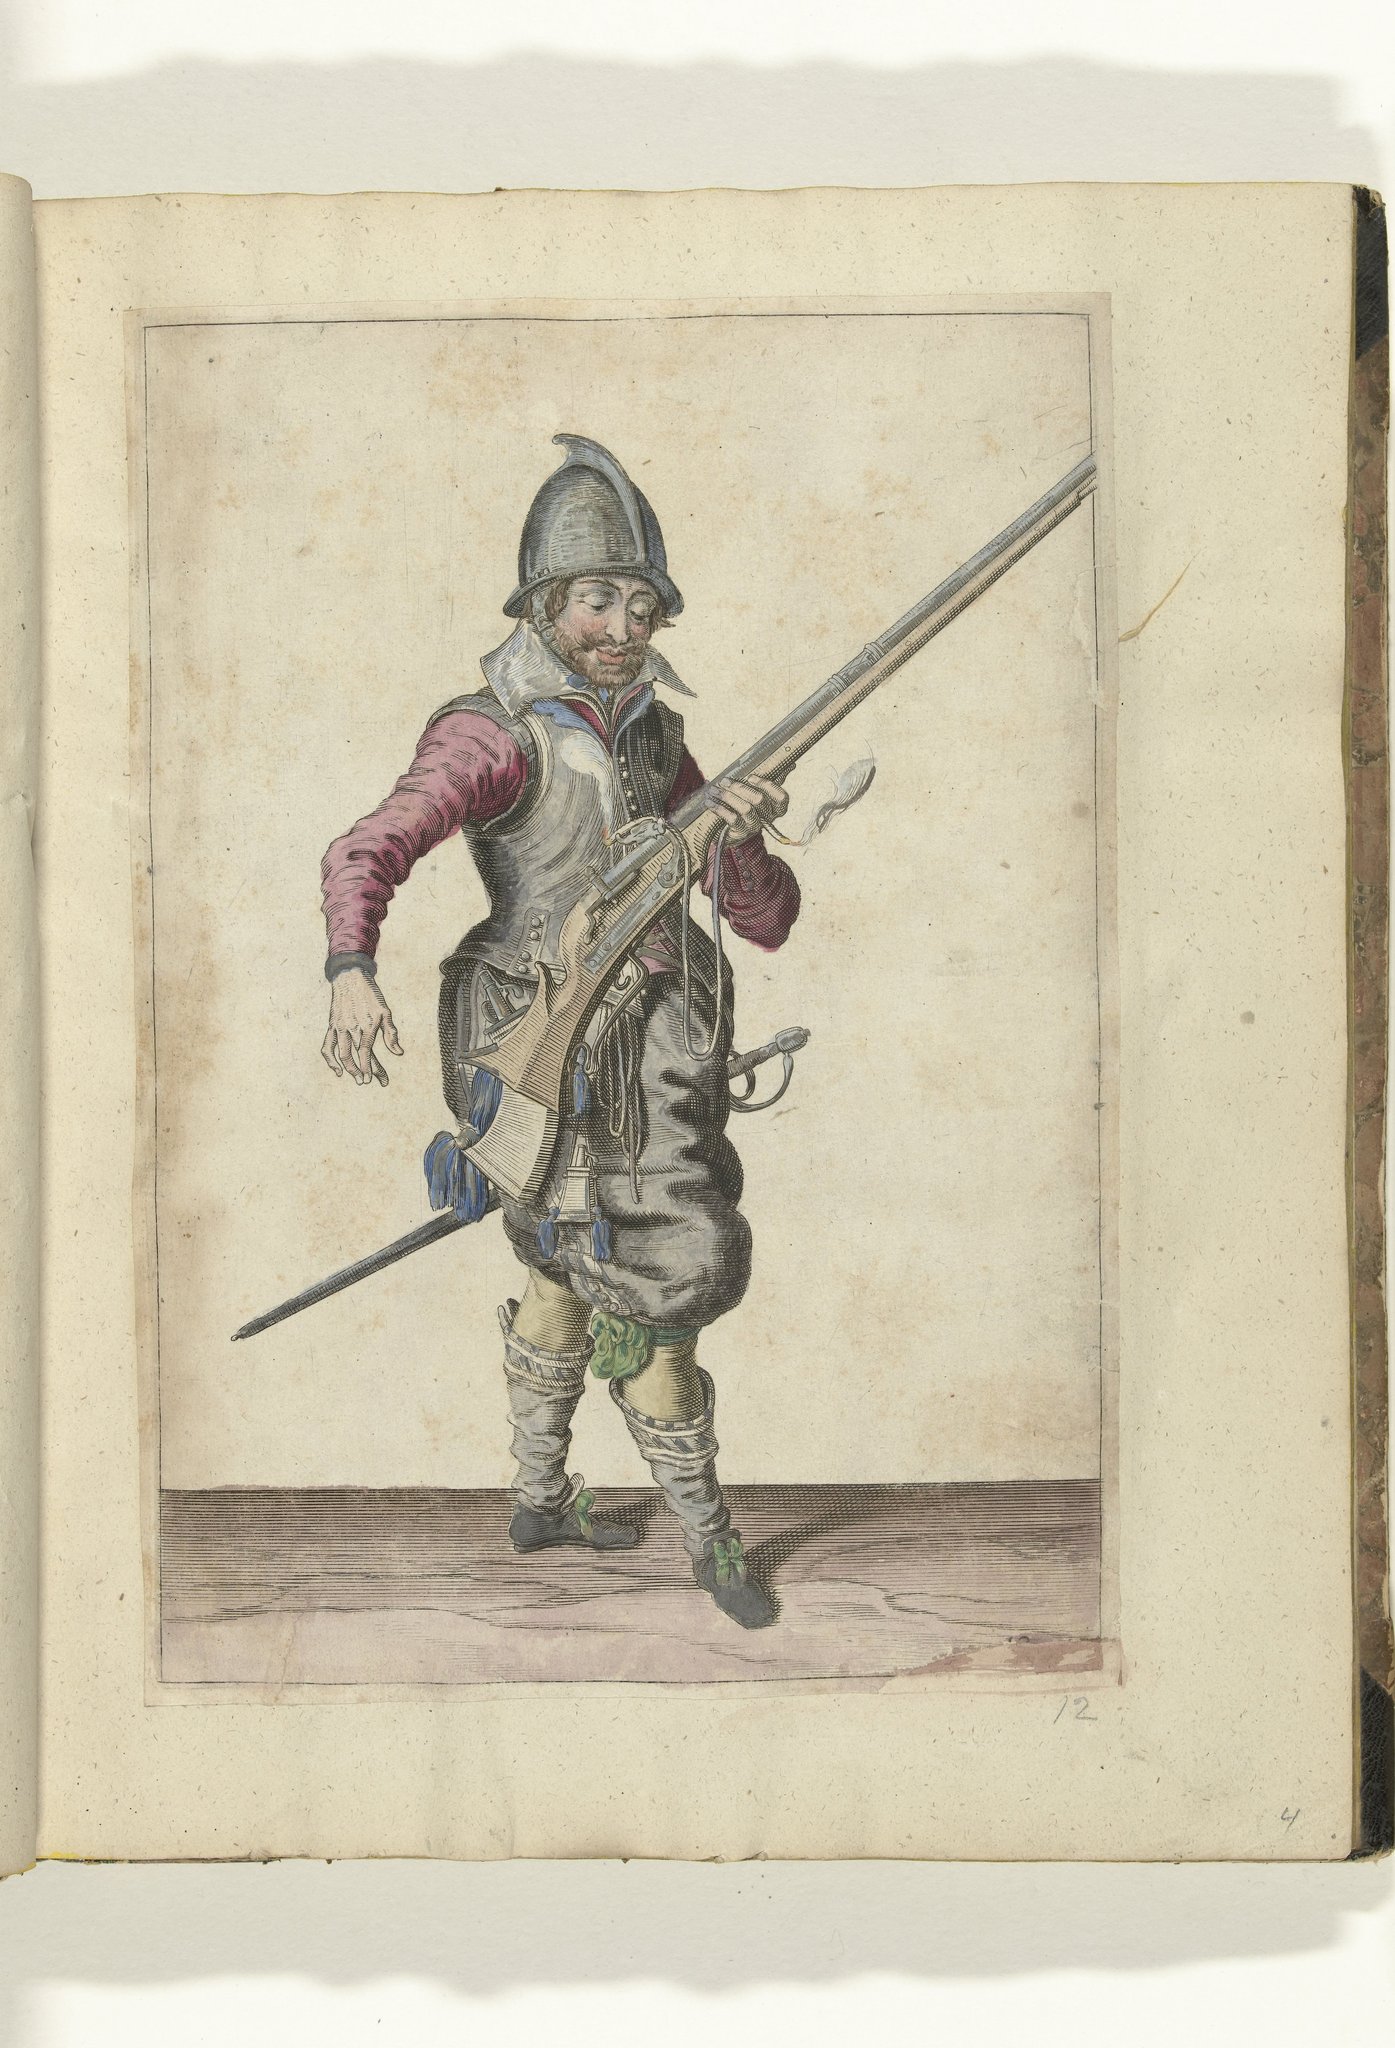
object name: print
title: Soldaat die zijn roer met zijn linkerhand schuin omhoog gericht vasthoudt (nr. 12), ca. 1600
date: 1597-1608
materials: paper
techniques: engraving, hand coloring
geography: northern netherlands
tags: maurice (prince of orange), handling of weapons ~ military training, weapons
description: Een soldaat, ten voeten uit, naar rechts, die een roer (een bepaald type vuurwapen) met zijn linkerhand vasthoudt, nadat hij gevuurd heeft, de loop schuin omhoog gericht om te voorkomen dat hij ongewild een gezel verwondt (nr. 12), ca. 1600. In zijn linkerhand behalve het roer ook een brandende lont. Plaat 12 in de instructies voor het hanteren van de roer: Shorte instruction upon the contrefaictinges, touching the right use of calivers. Onderdeel van de illustraties in een Engelse editie van J. de Gheyns Wapenhandelinghe: J. de Gheyn, The exercise of armes for calivres, muskettes and pikes after the ordre of Maurits Prince of Orange, 's-Gravenhage 1608. Krijgswezen rond 1600.